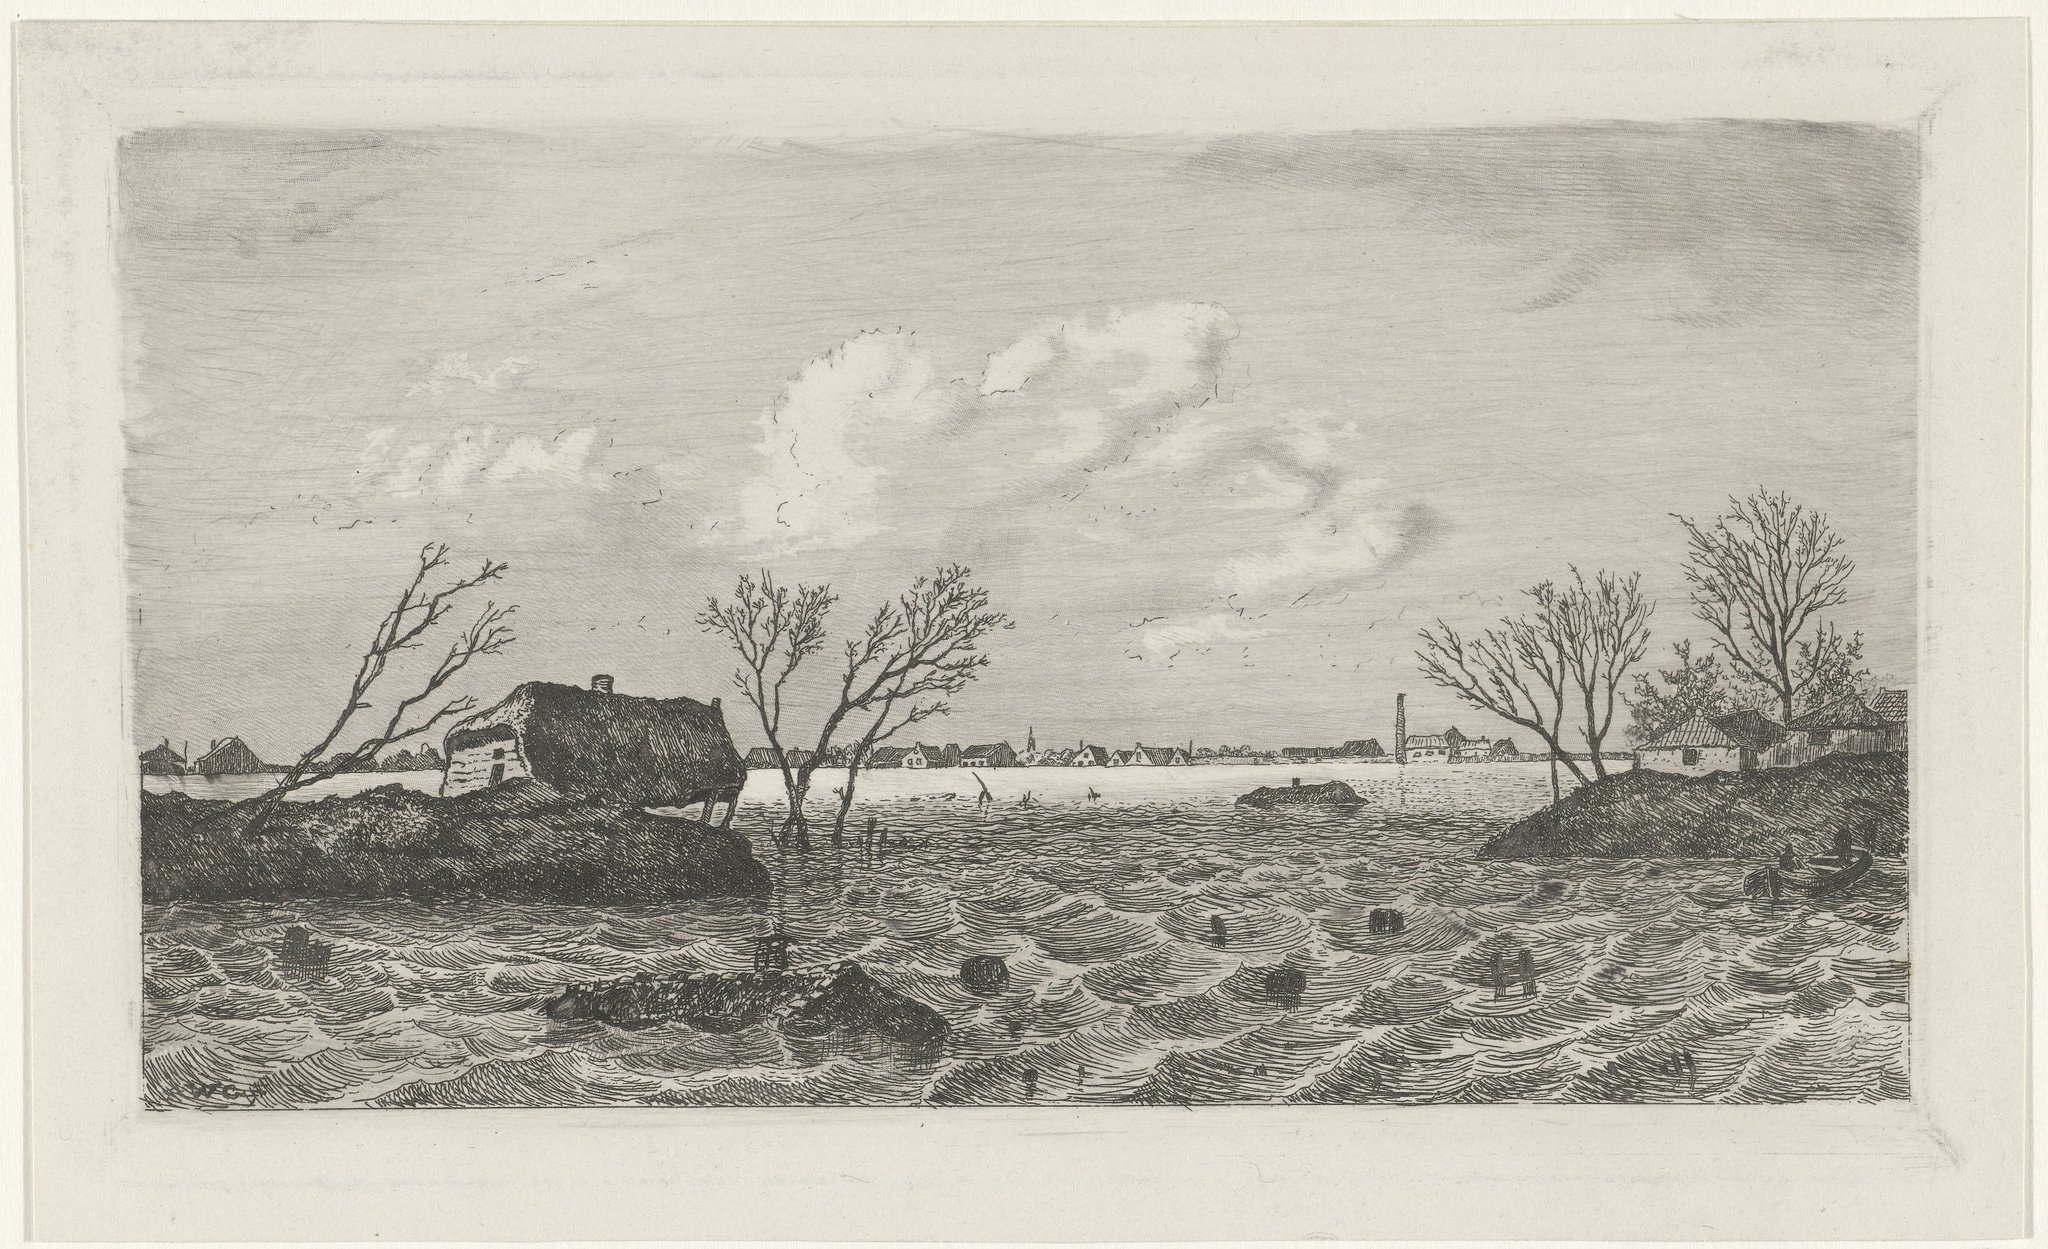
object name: print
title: Dijkdoorbraak bij Dreumel, 1855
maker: willem gruyter jr.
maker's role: draughtsman, print maker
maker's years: 1817-1880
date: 1832-1880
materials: paper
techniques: aquatint, etching, roulette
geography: amsterdam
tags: dike-break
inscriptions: collector's mark: Lugt 2165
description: Landschap met dijkdoorbraak bij Dreumel tijdens de watersnoodramp in 1855.